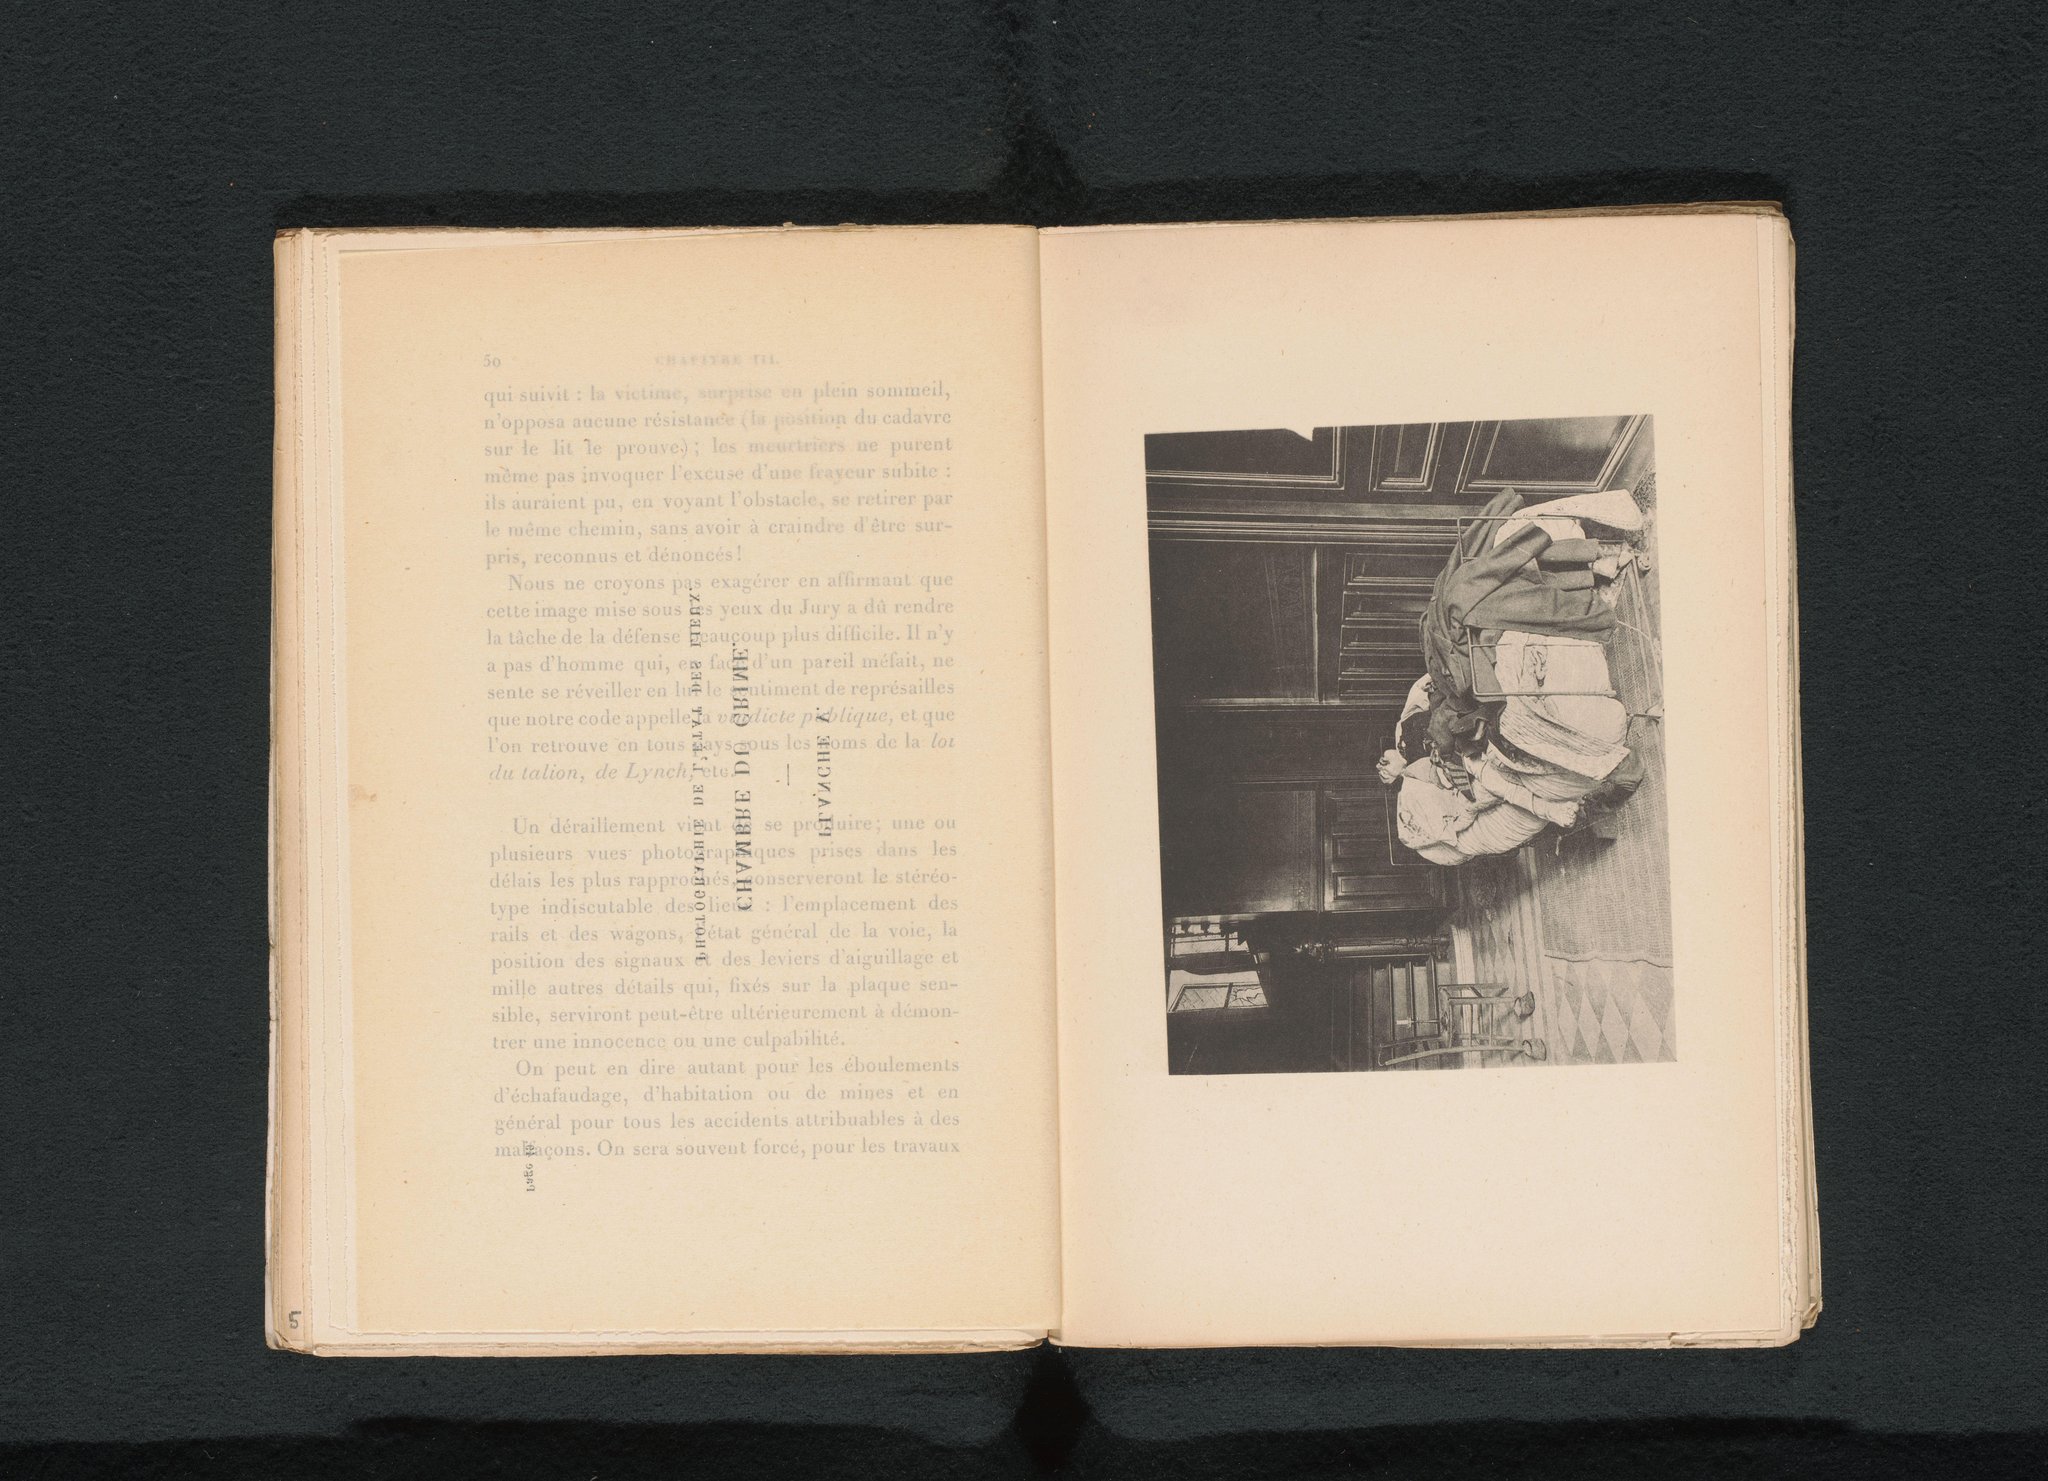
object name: photomechanical print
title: Gezicht op een plaats delict, waar een man dood in een bed ligt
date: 1885-1890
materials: paper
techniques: photograph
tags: visiting the scene of the crime